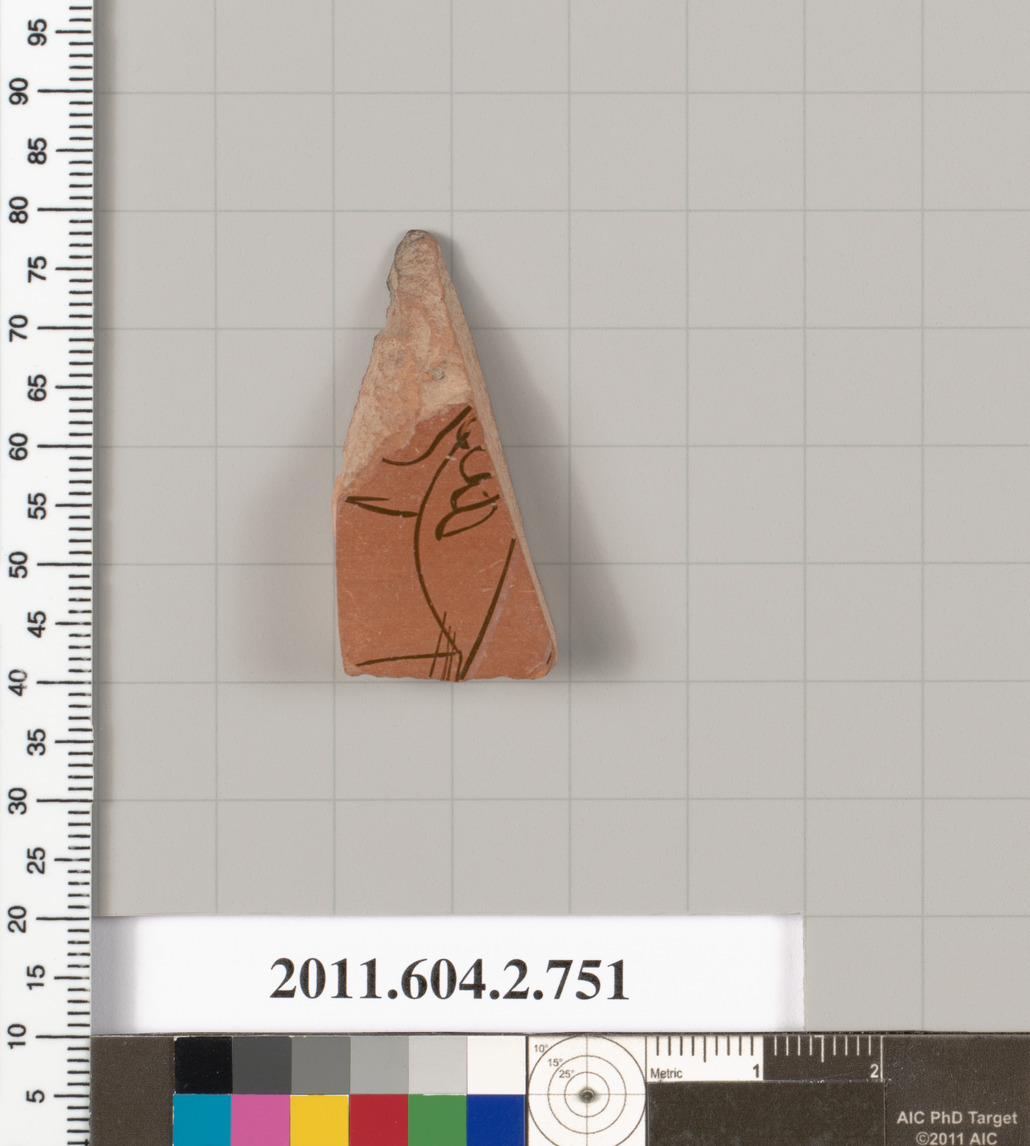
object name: calyx krater fragment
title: Terracotta fragment of a calyx-krater (bowl for mixing wine and water)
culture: greek, attic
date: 475-451 BCE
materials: terracotta